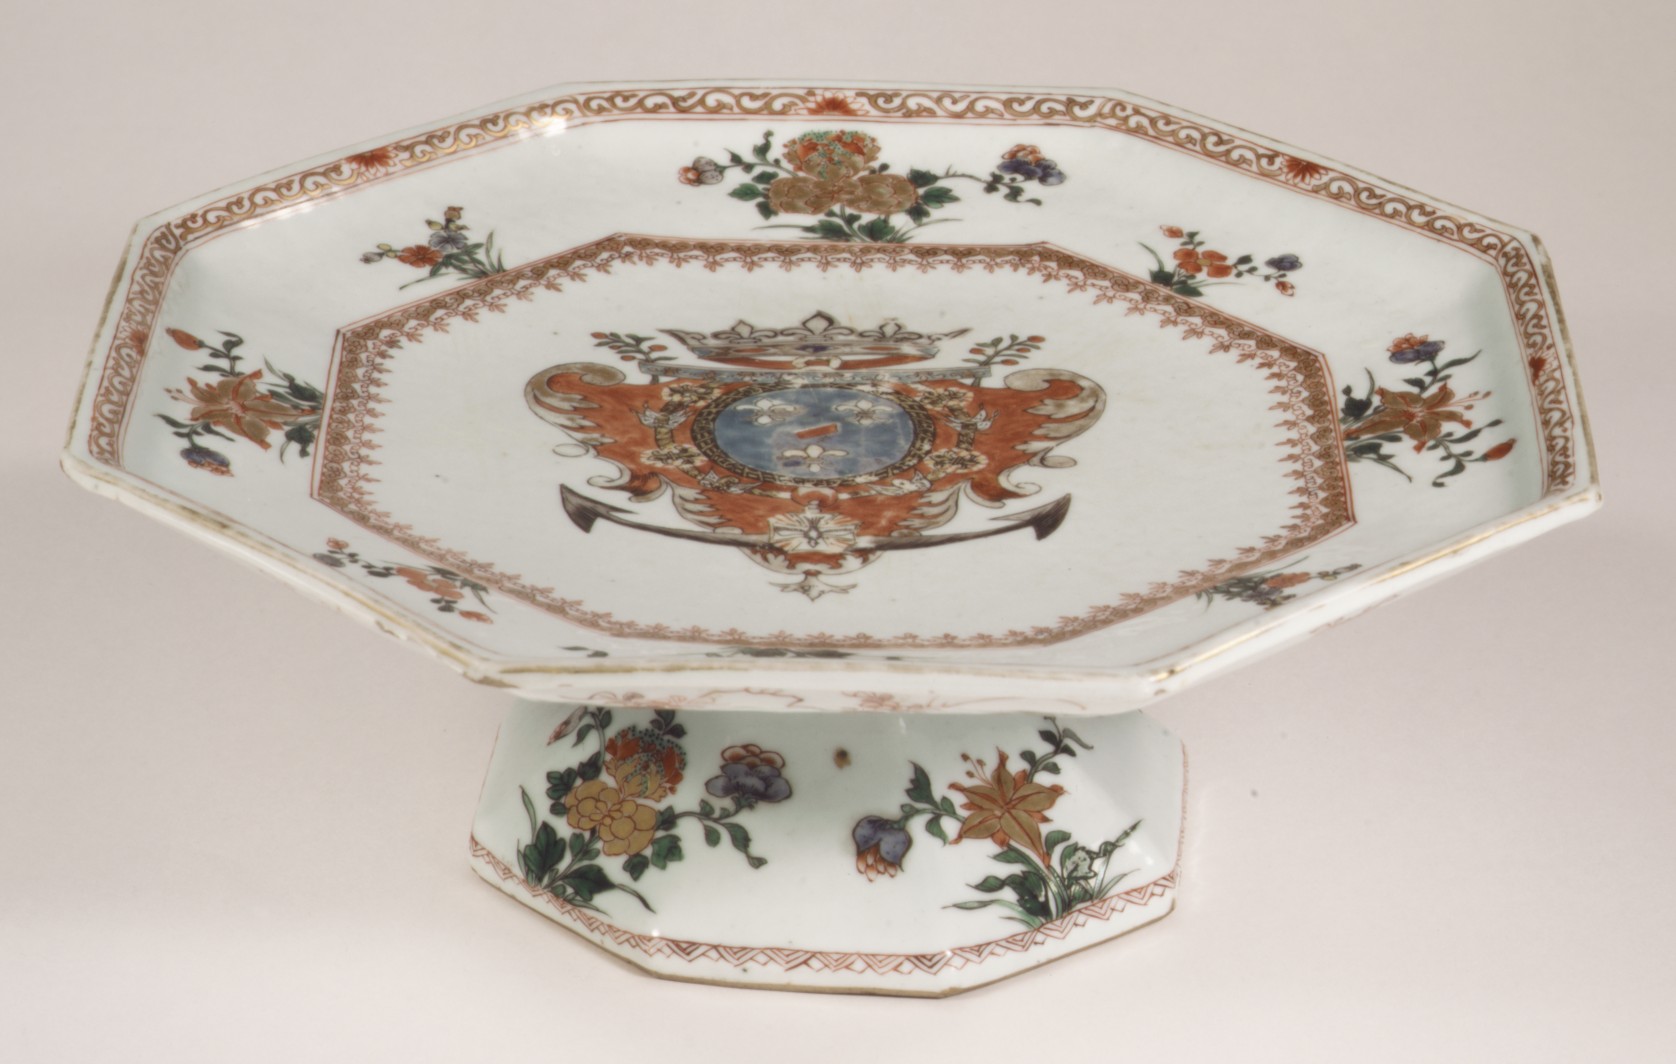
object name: tazza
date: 1740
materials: hard paste porcelain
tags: flowers,coat of arms